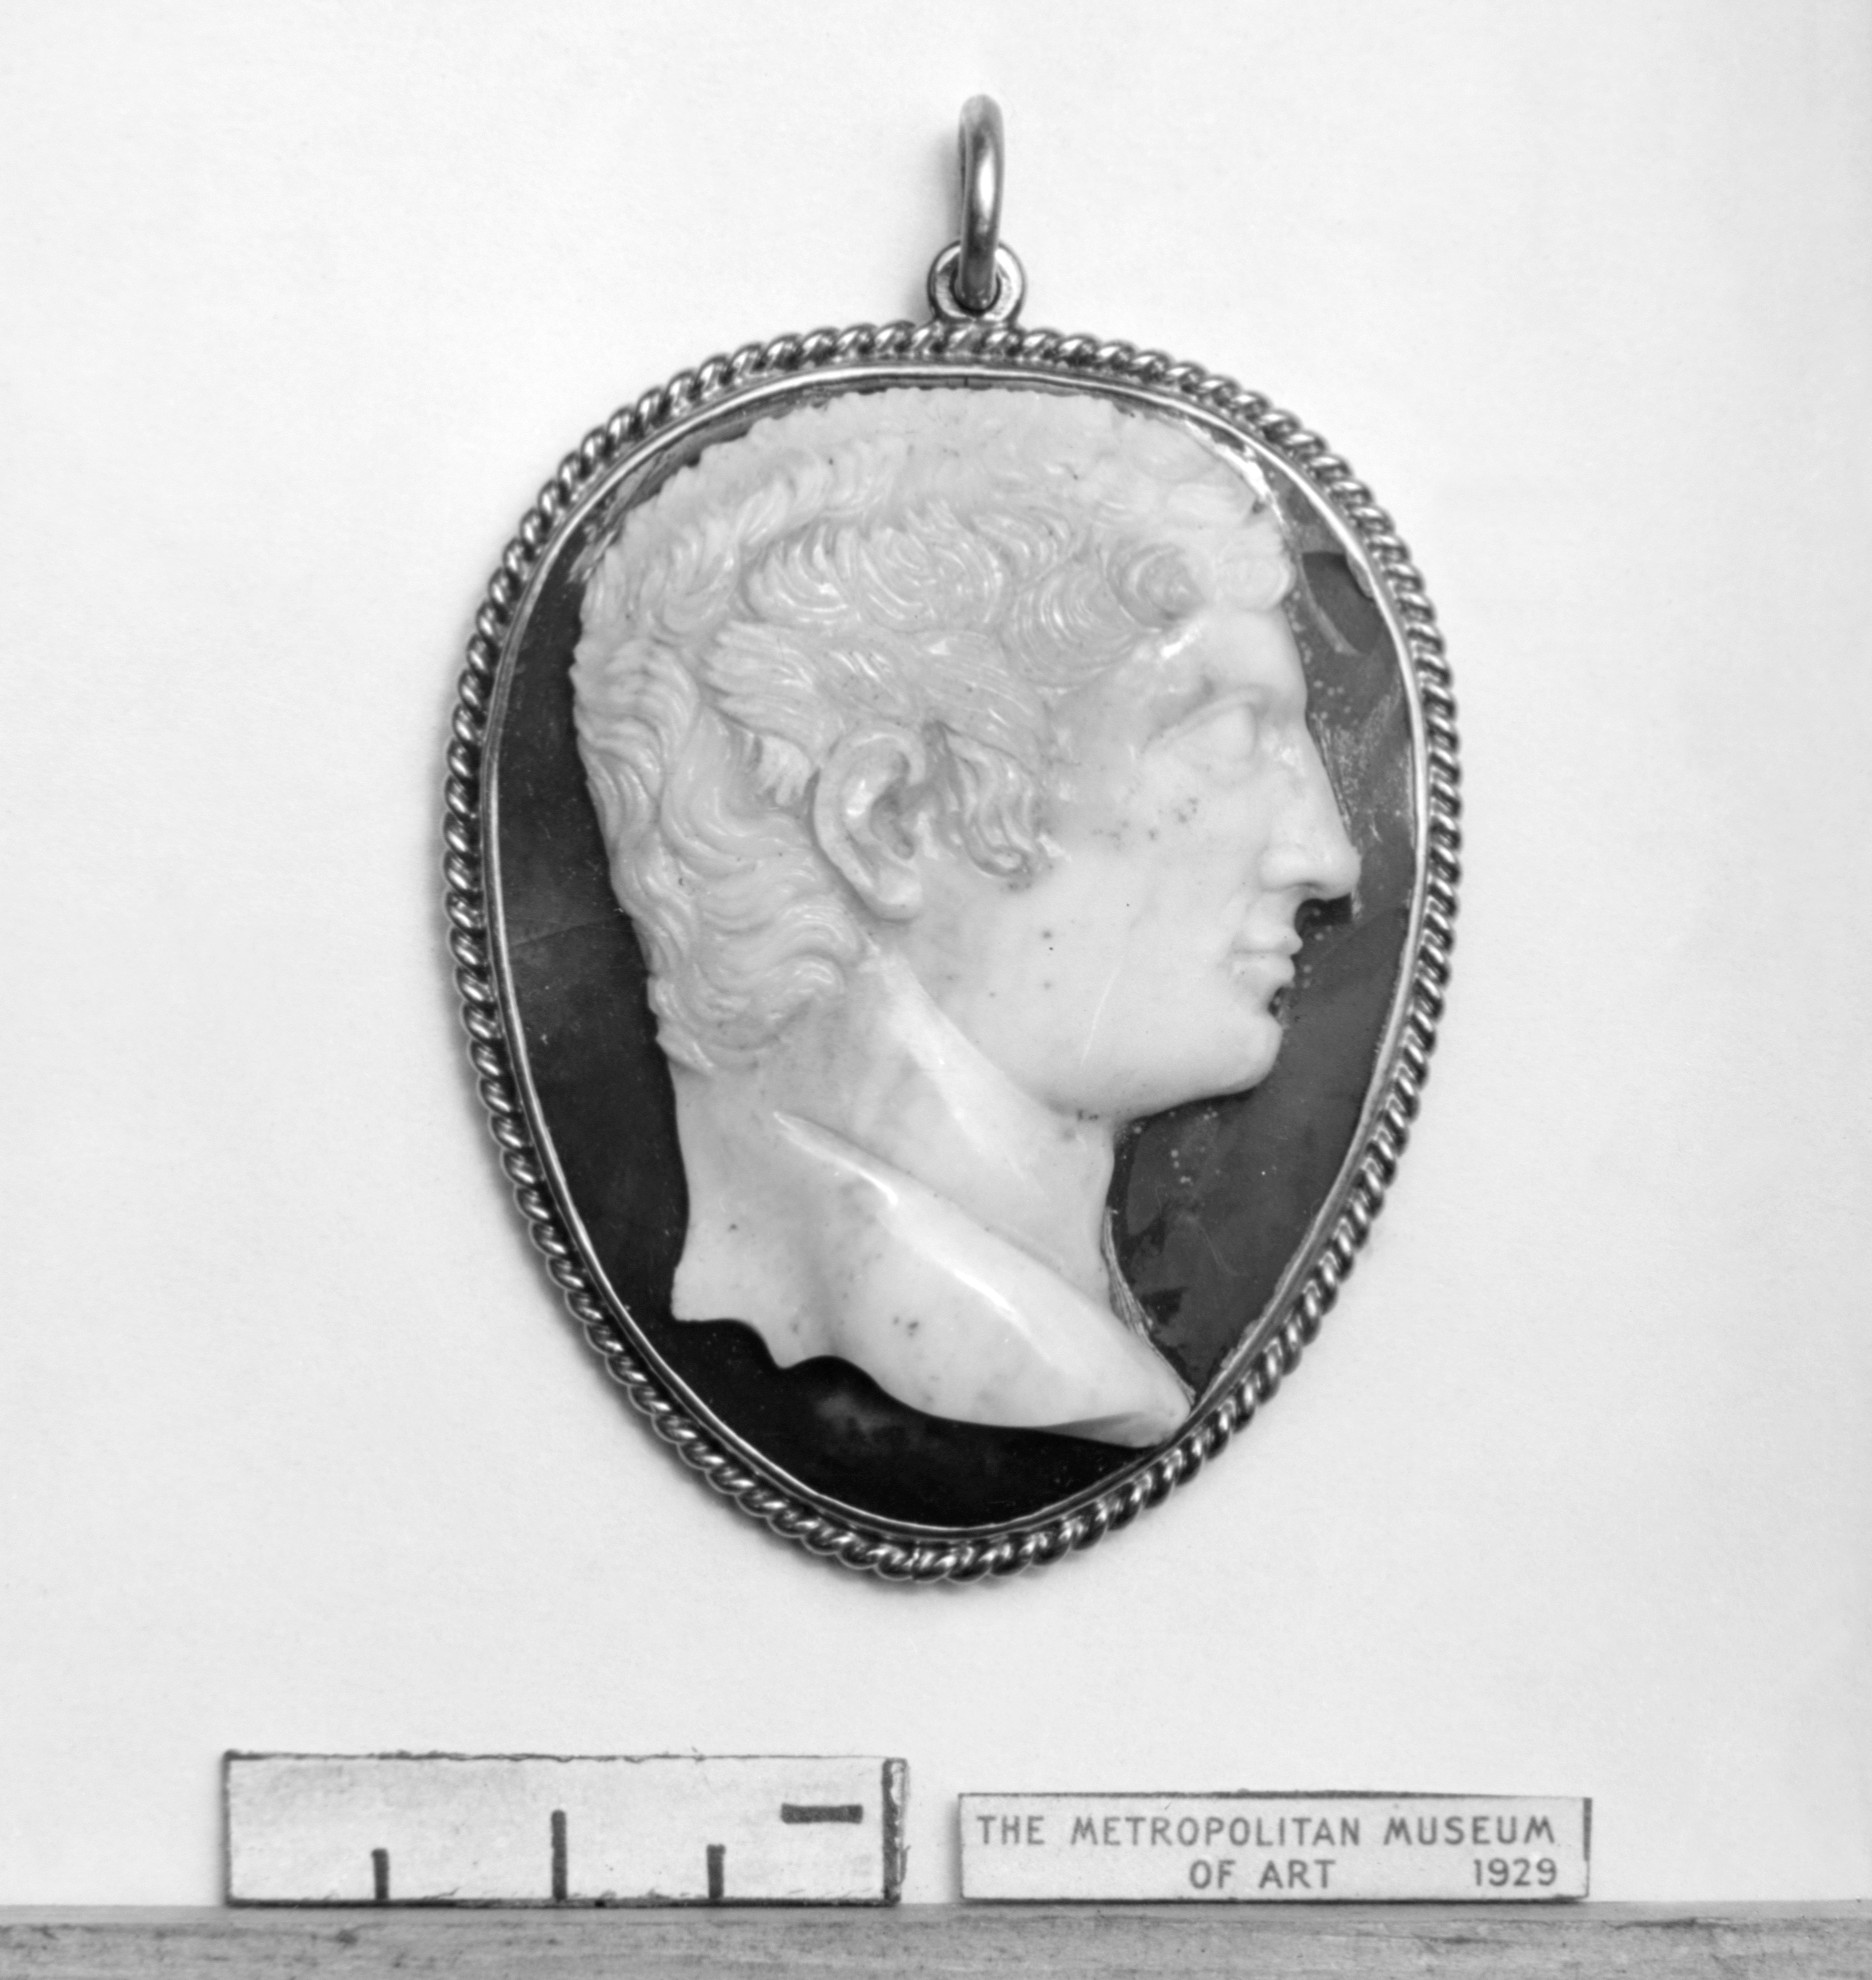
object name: cameo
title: Germanicus (15 B.C.–19 A.D.) (?)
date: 1601-1800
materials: gold, gemstone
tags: men,profiles